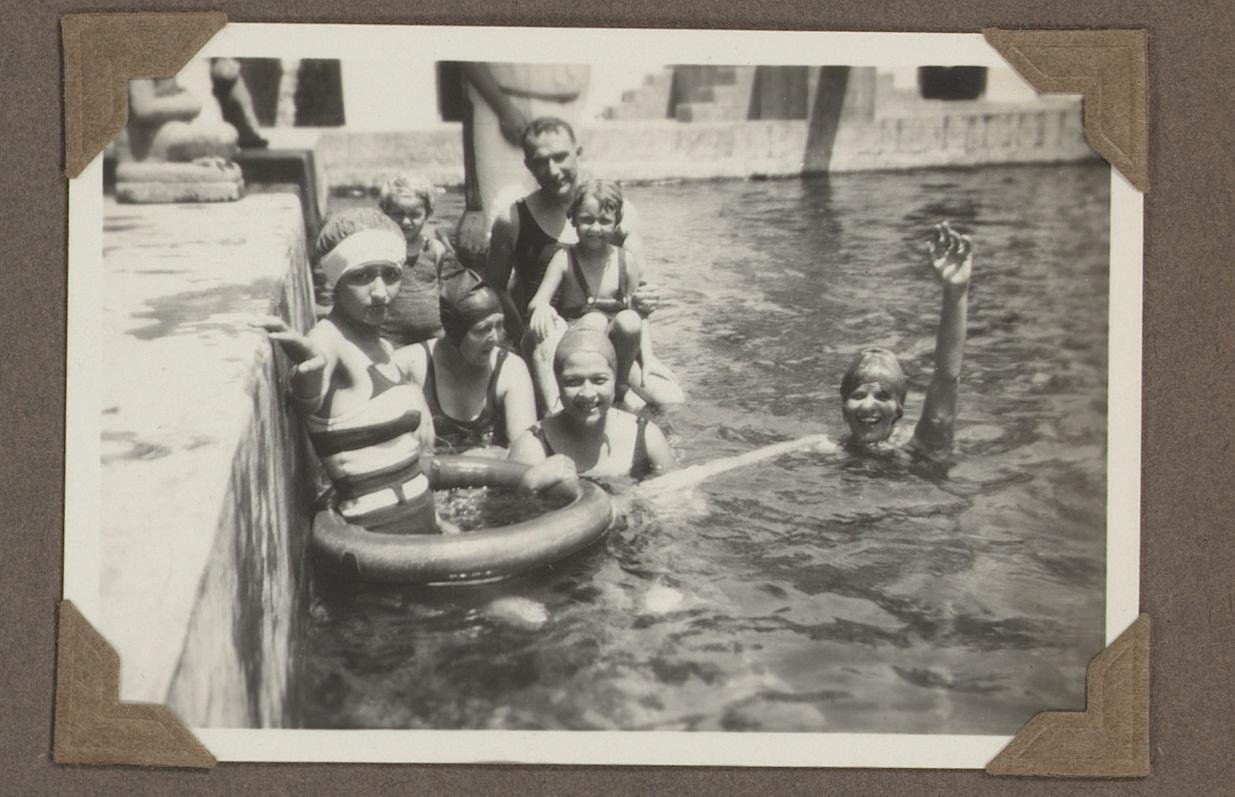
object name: album leaf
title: Dootje en Wilhelmina van Zijll de Jong met anderen zwemmend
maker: Anonymous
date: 1930-1935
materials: paper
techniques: gelatin silver print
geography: dutch east indies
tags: amsterdam, the hague, wilhelmina van zijll de jong, swimming (movement in water), dutch east indies, the